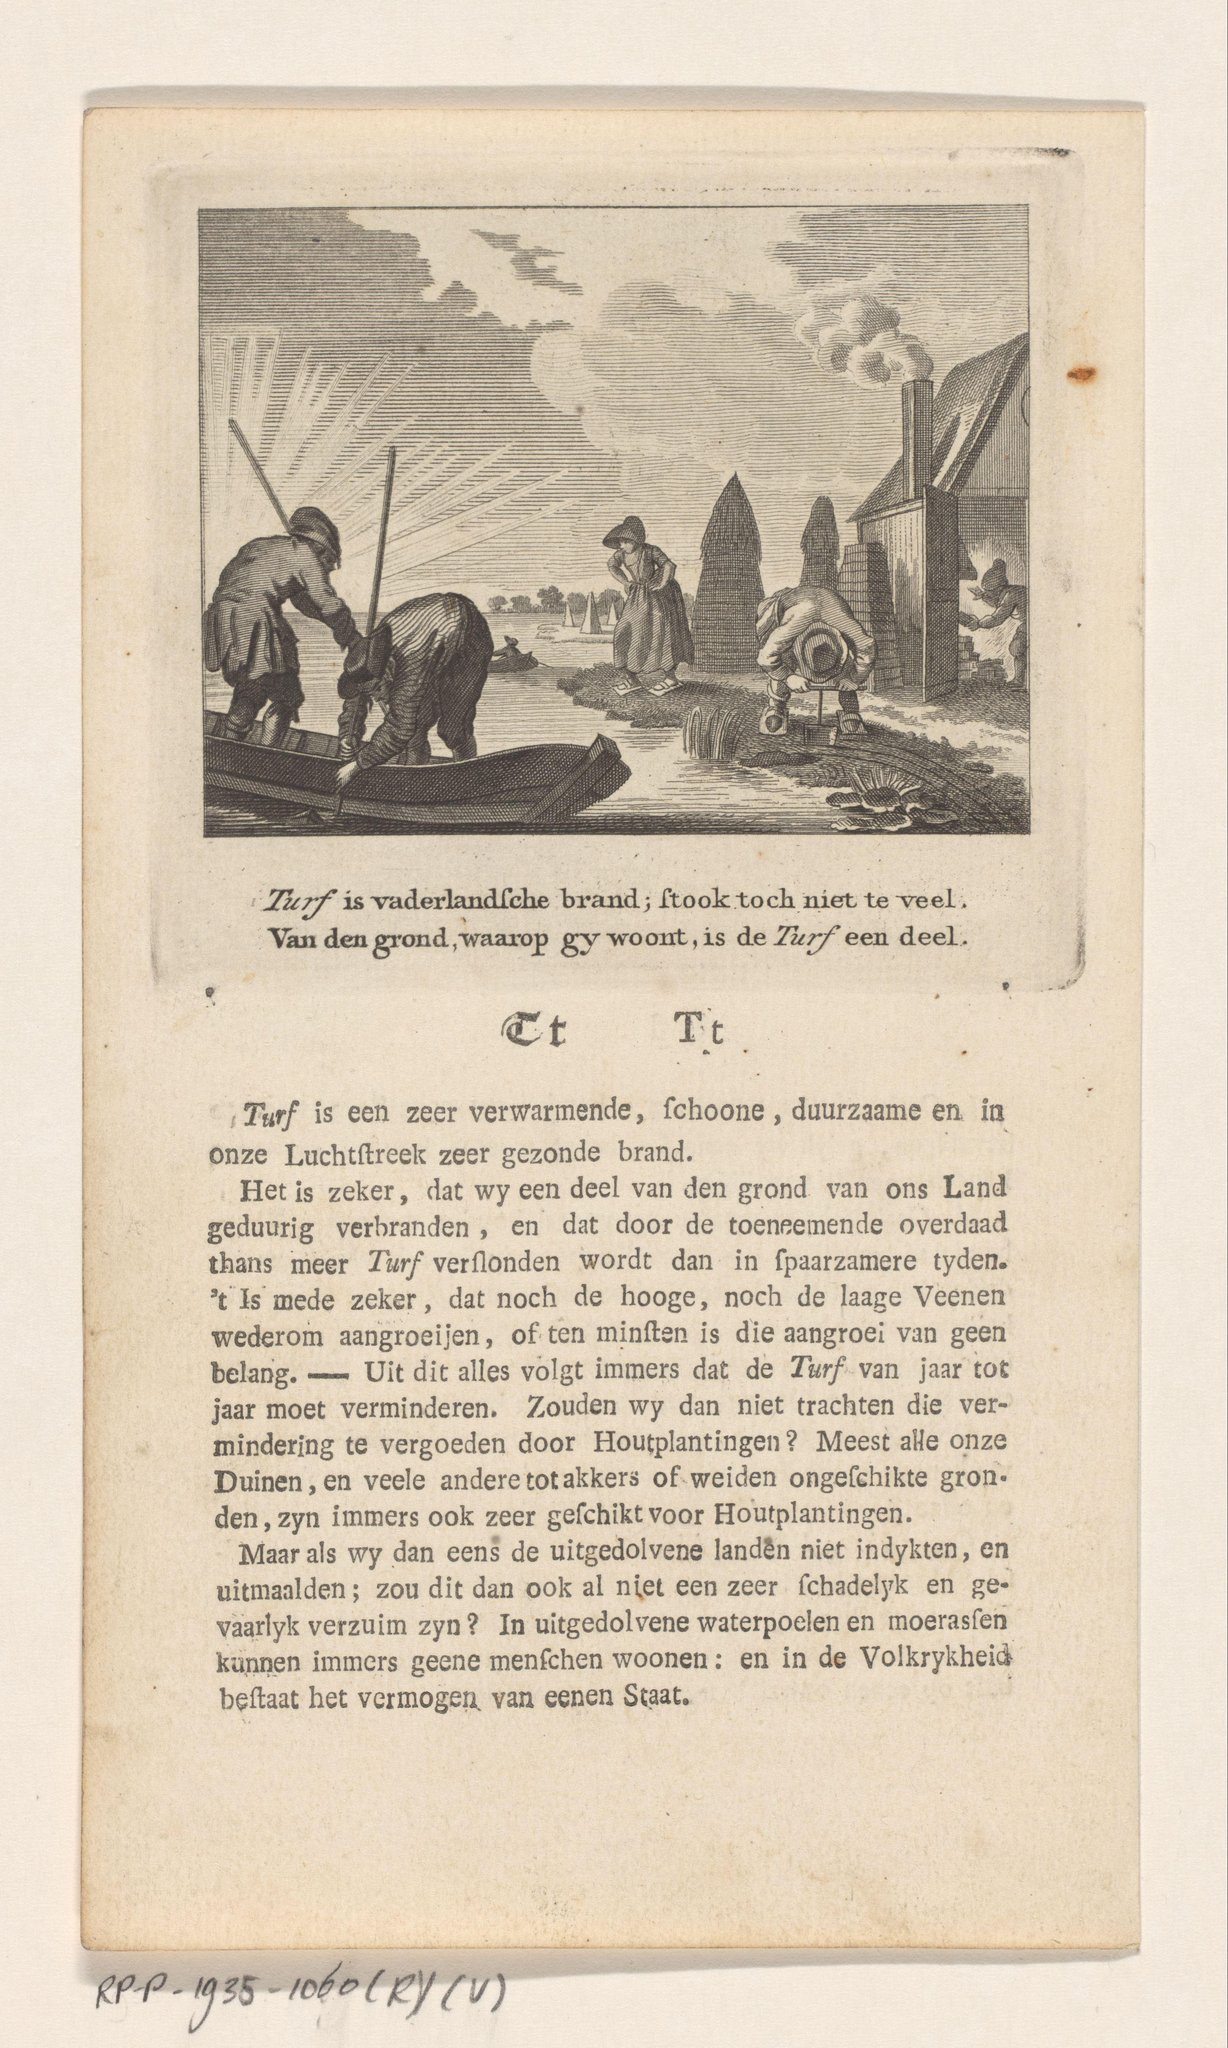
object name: print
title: Turfstekers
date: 1781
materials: paper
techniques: etching, letterpress printing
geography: amsterdam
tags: peat (soil type), peat-cutting, open hearth, fire-place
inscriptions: collector's mark: Lugt 2228, collector's mark: Lugt 2760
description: Twee turfstekers in een schuit. Op de kant eveneens een turfsteker. Rechts wordt de turf gebruikt als brandstof in de haard van een huis. Onderaan een verklarende tekst bij de letter T.